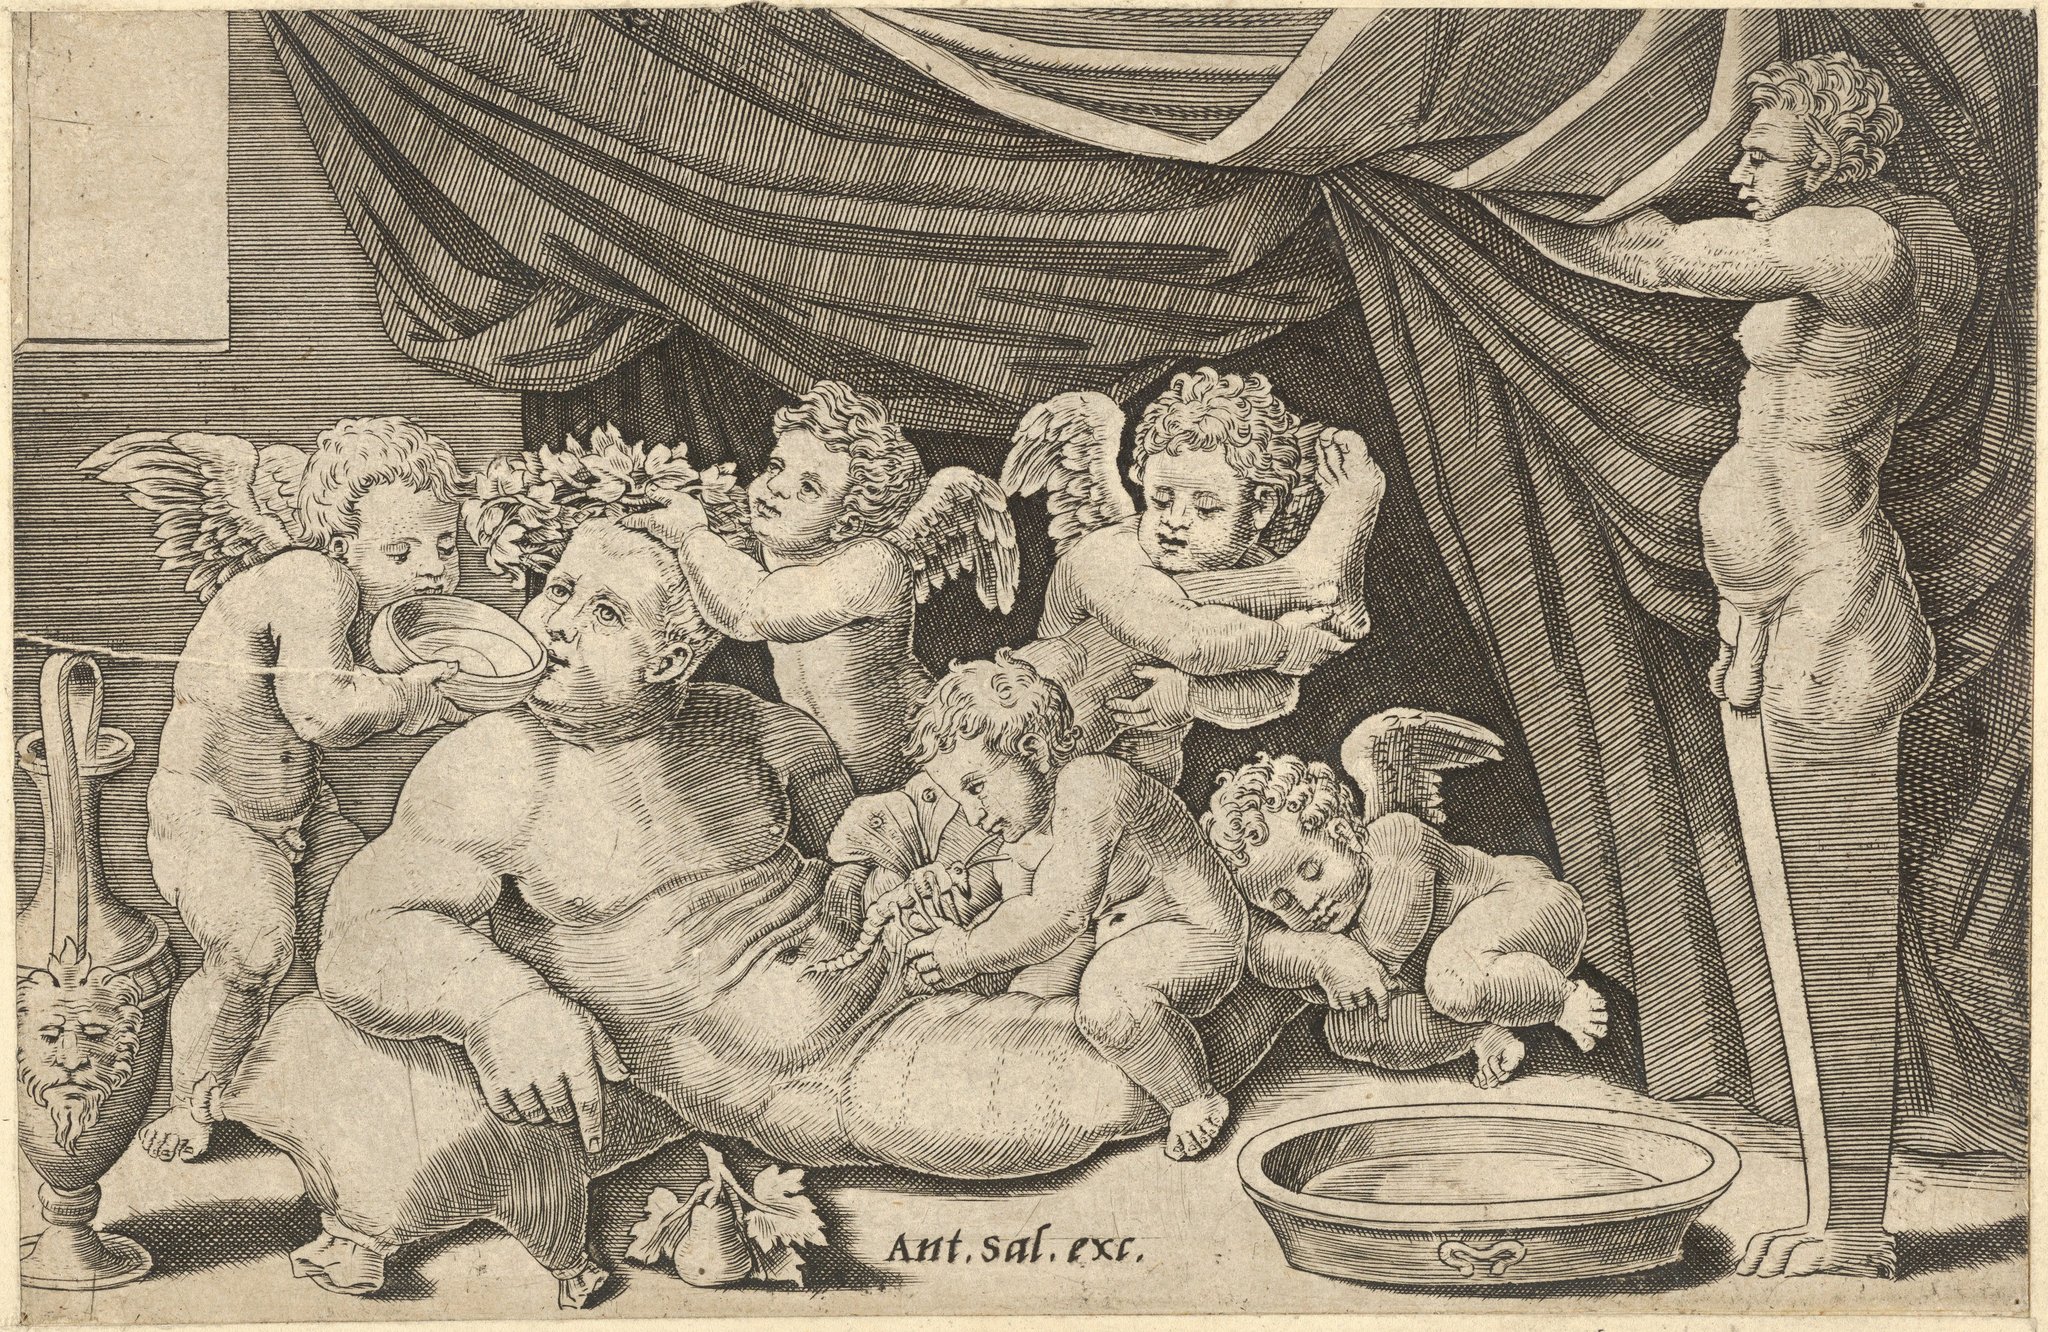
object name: print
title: Bacchus Surrounded by Putti with Priapus holding back the curtain, from "Speculum Romanae Magnificentiae"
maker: master of the die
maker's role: artist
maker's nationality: italian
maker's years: 1525-1560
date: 1501-1600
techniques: engraving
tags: putti,bacchus,butterflies,drinking